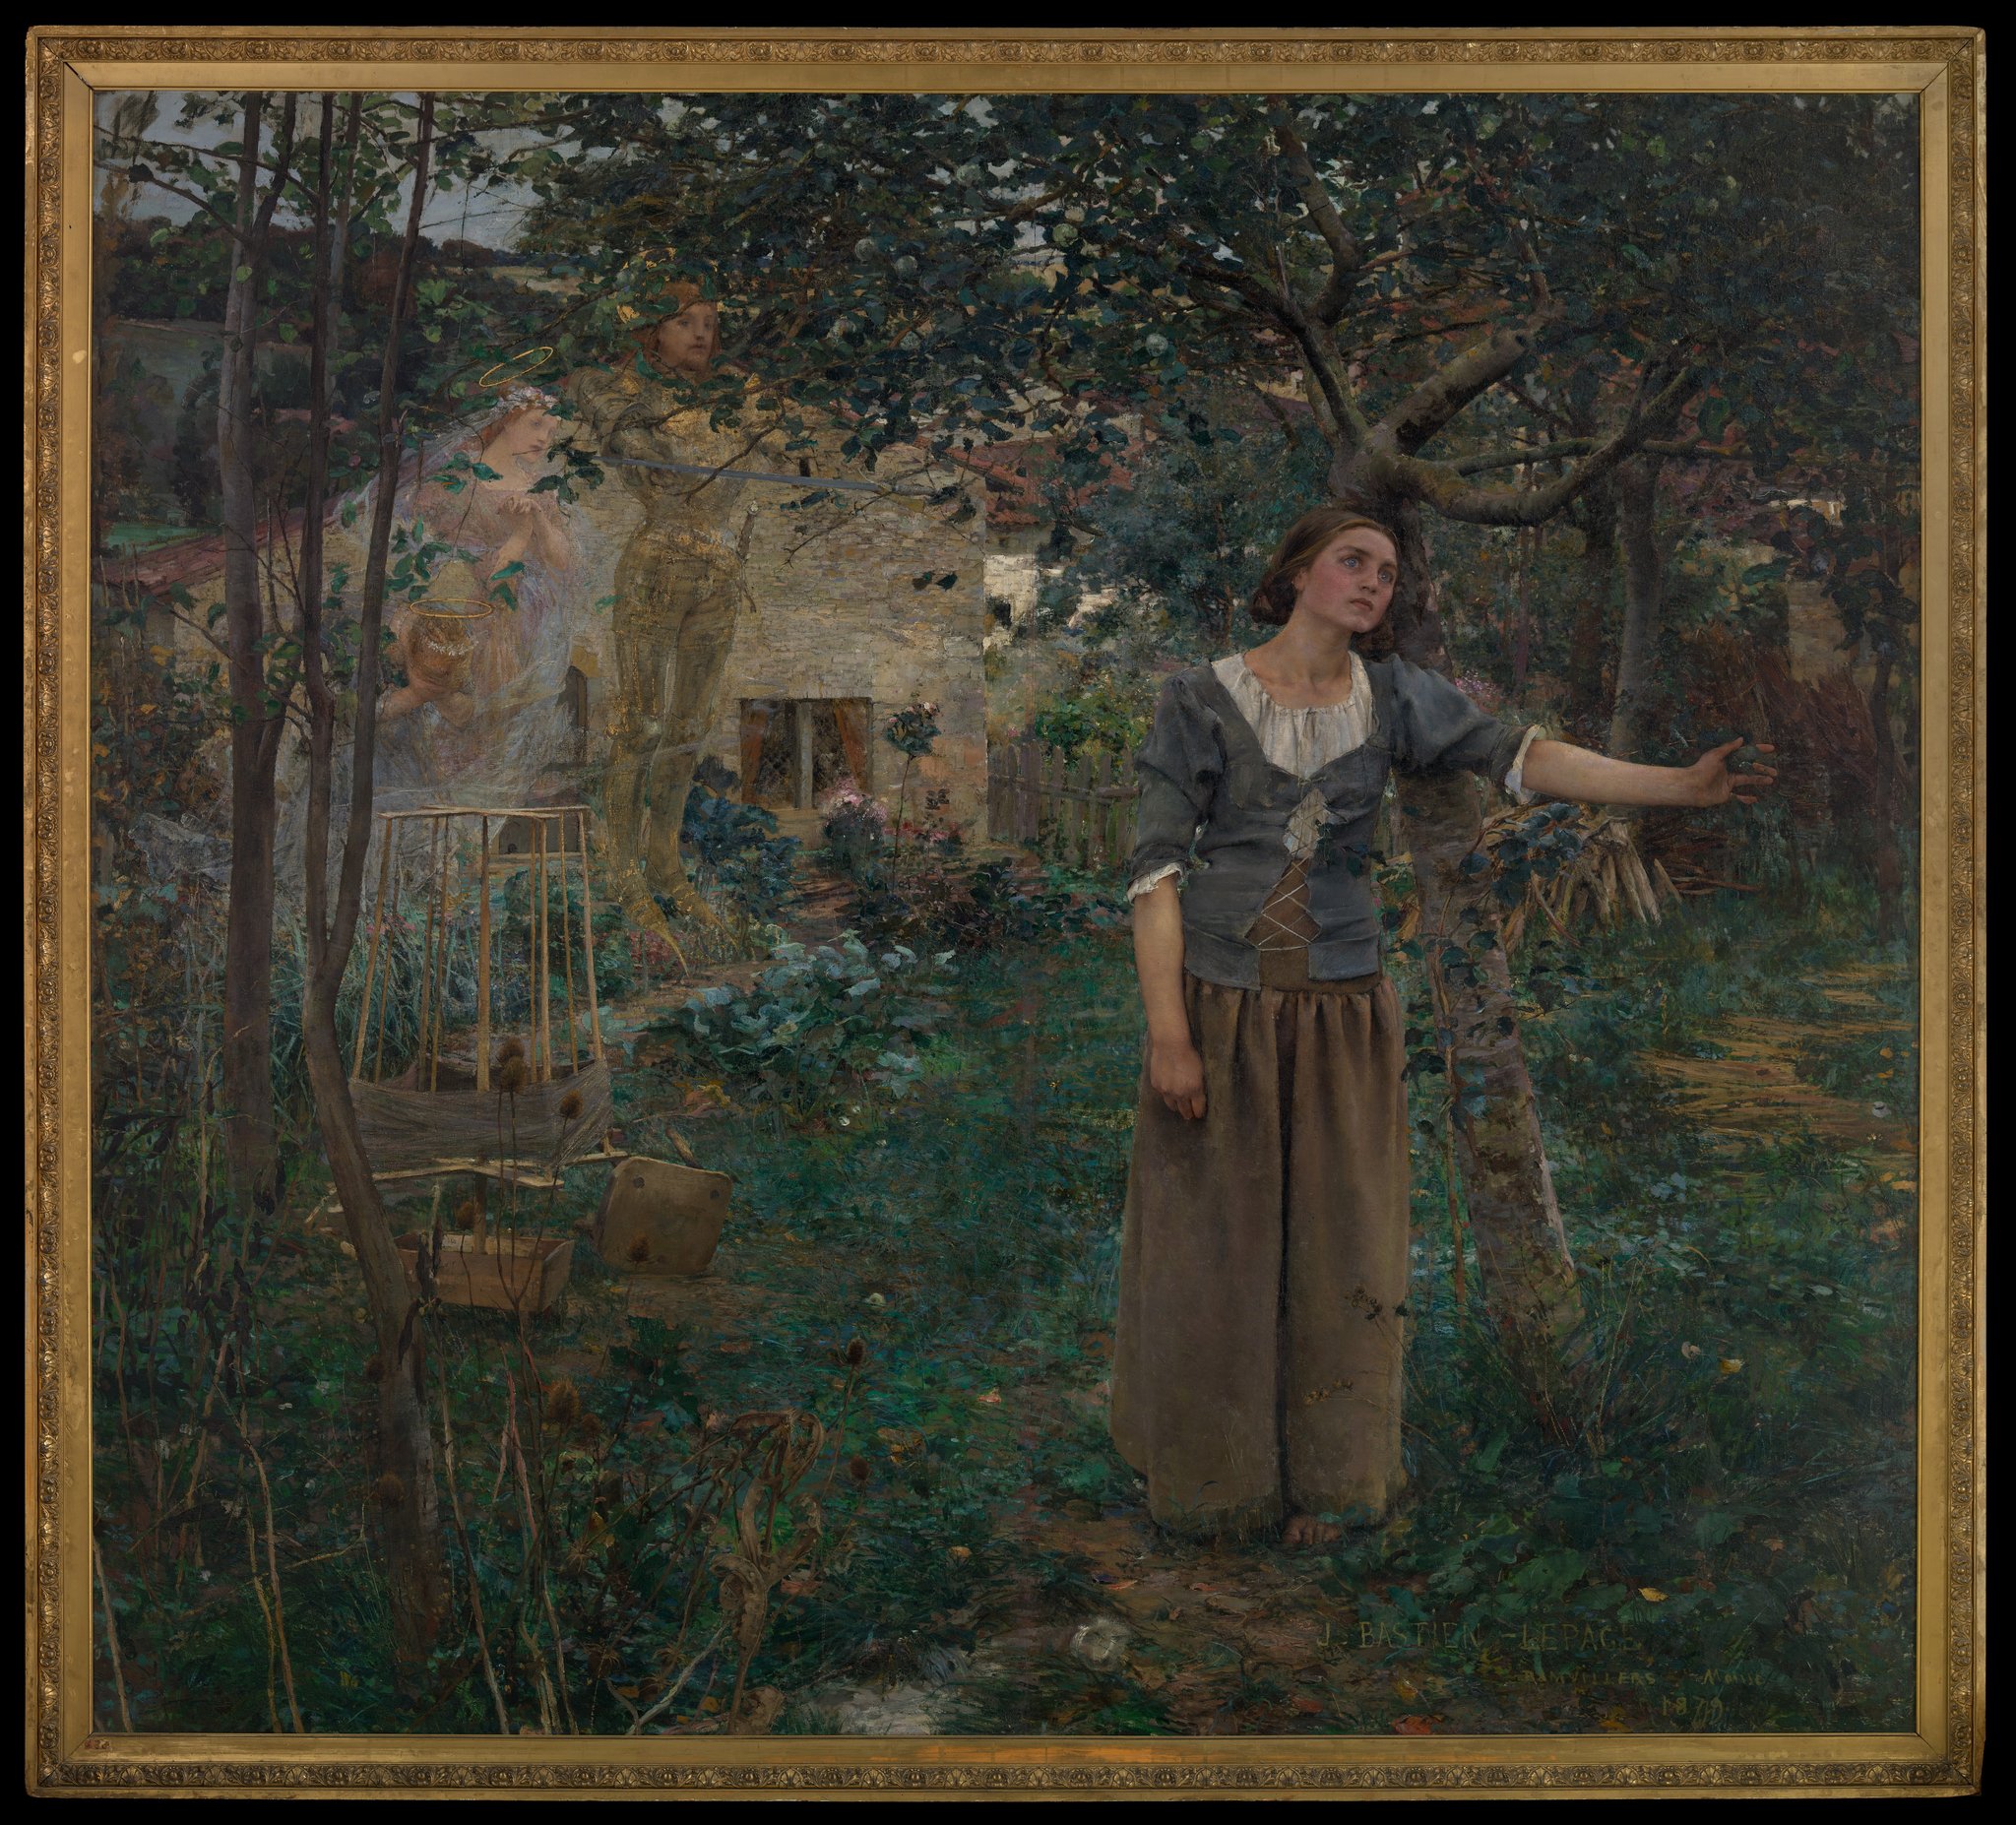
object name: painting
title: Joan of Arc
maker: jules bastien-lepage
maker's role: artist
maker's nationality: french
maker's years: 1848-1884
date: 1879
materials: canvas, oil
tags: gardens,joan of arc